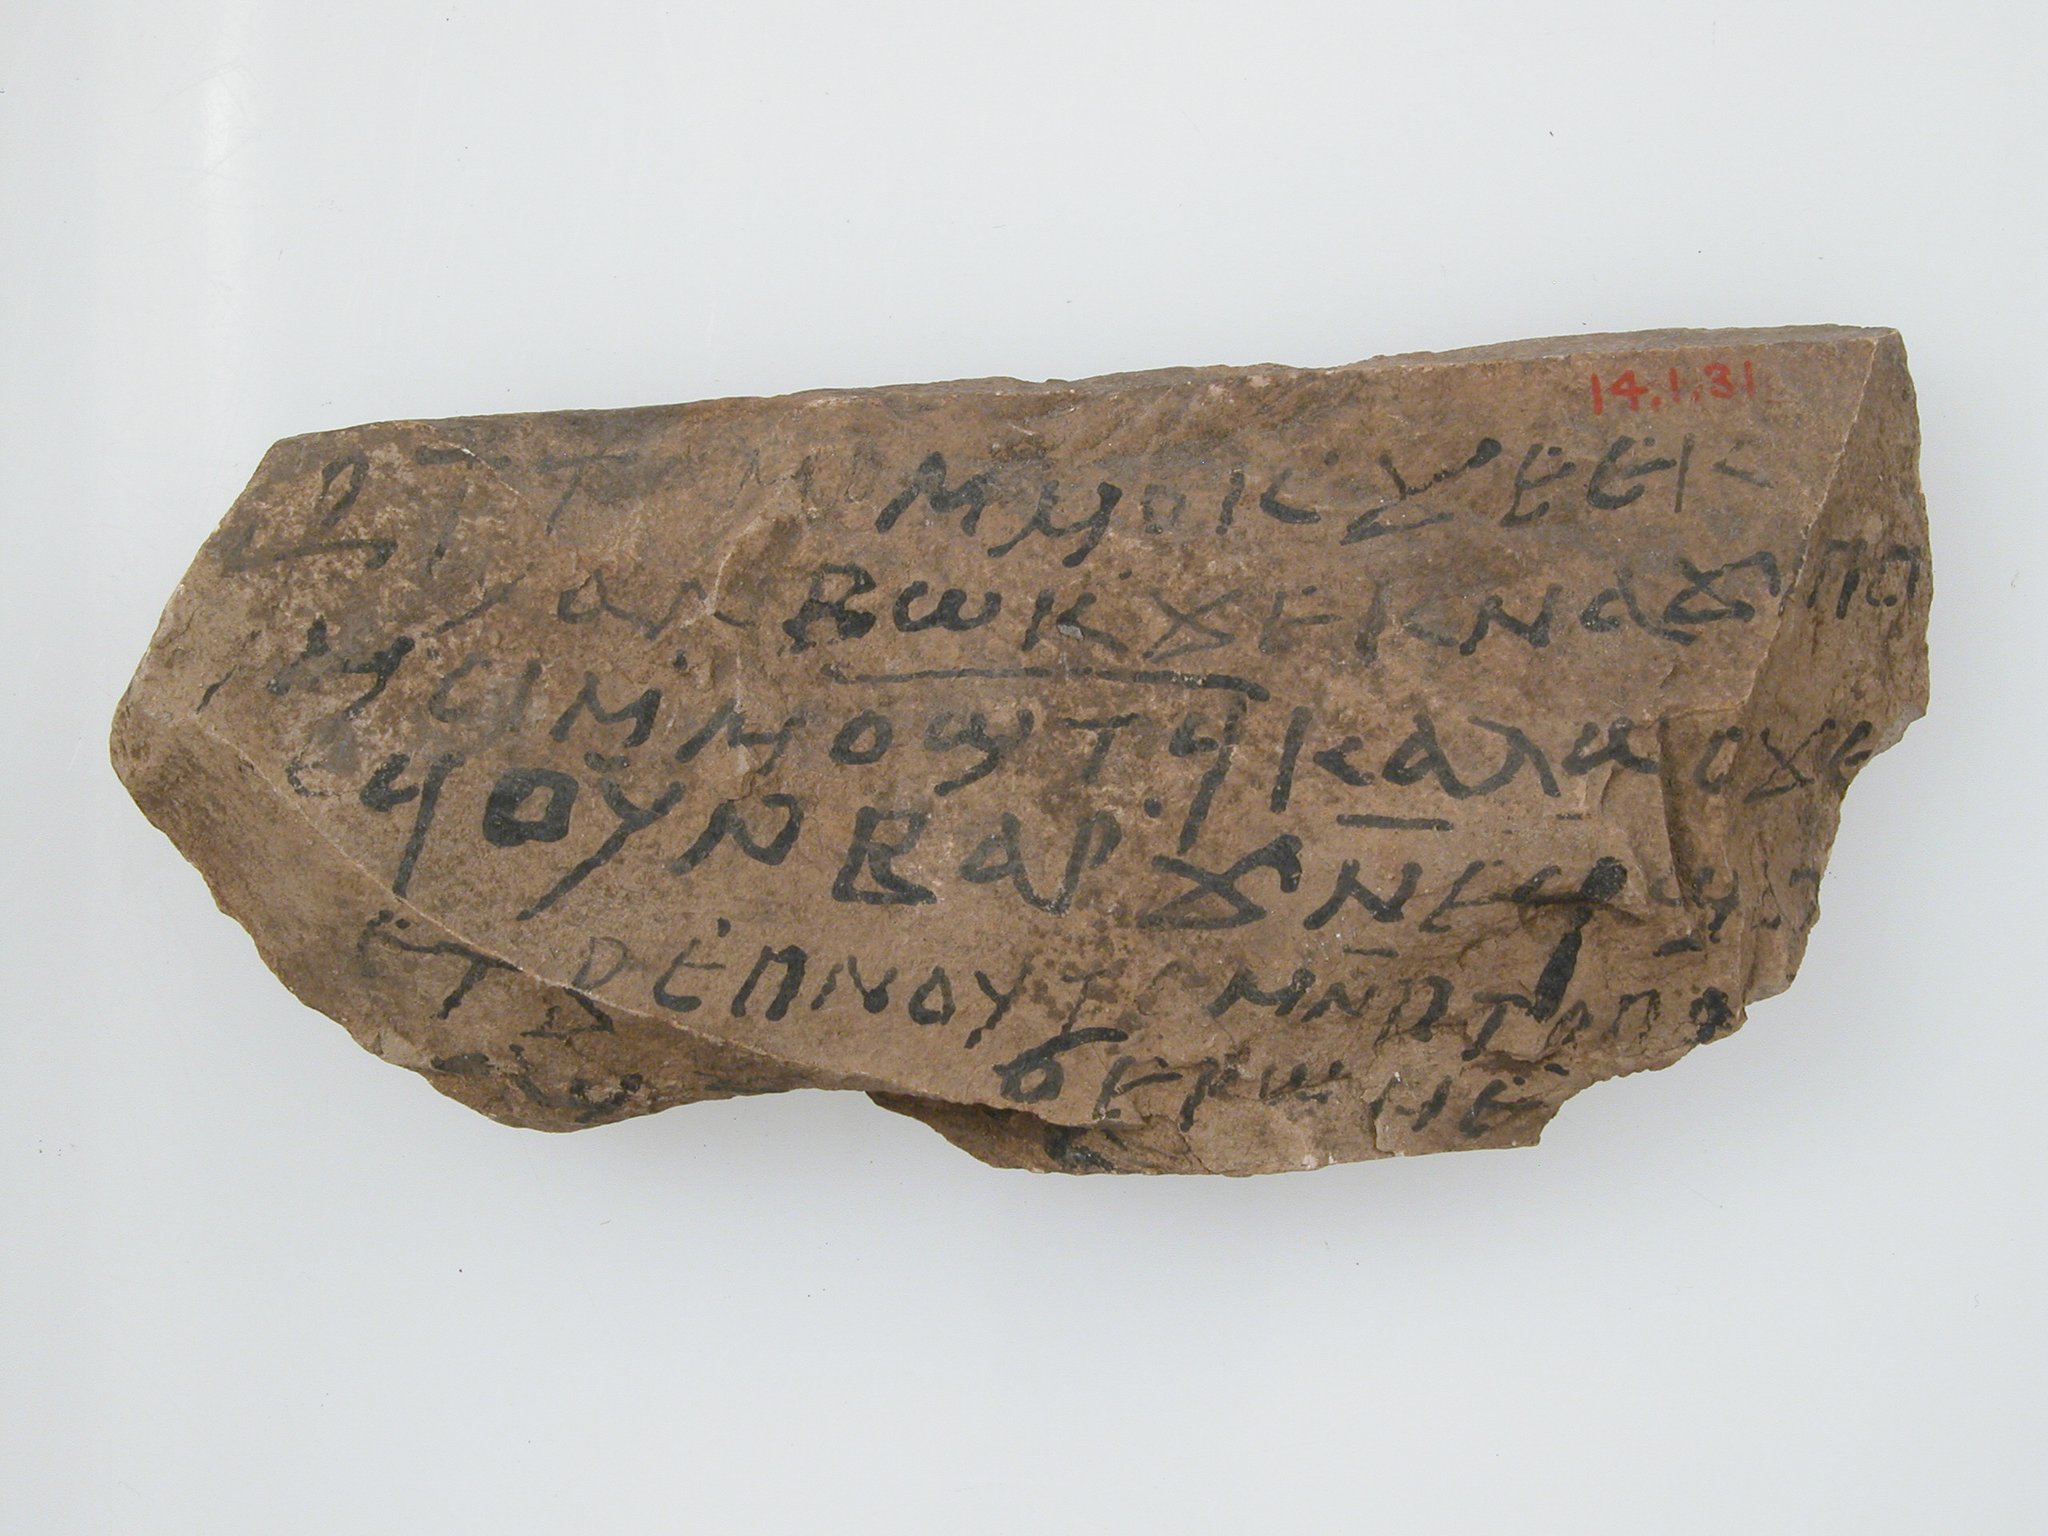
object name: ostrakon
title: Ostrakon with a Letter from Kame to Aaron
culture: coptic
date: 600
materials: ink, limestone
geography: egypt